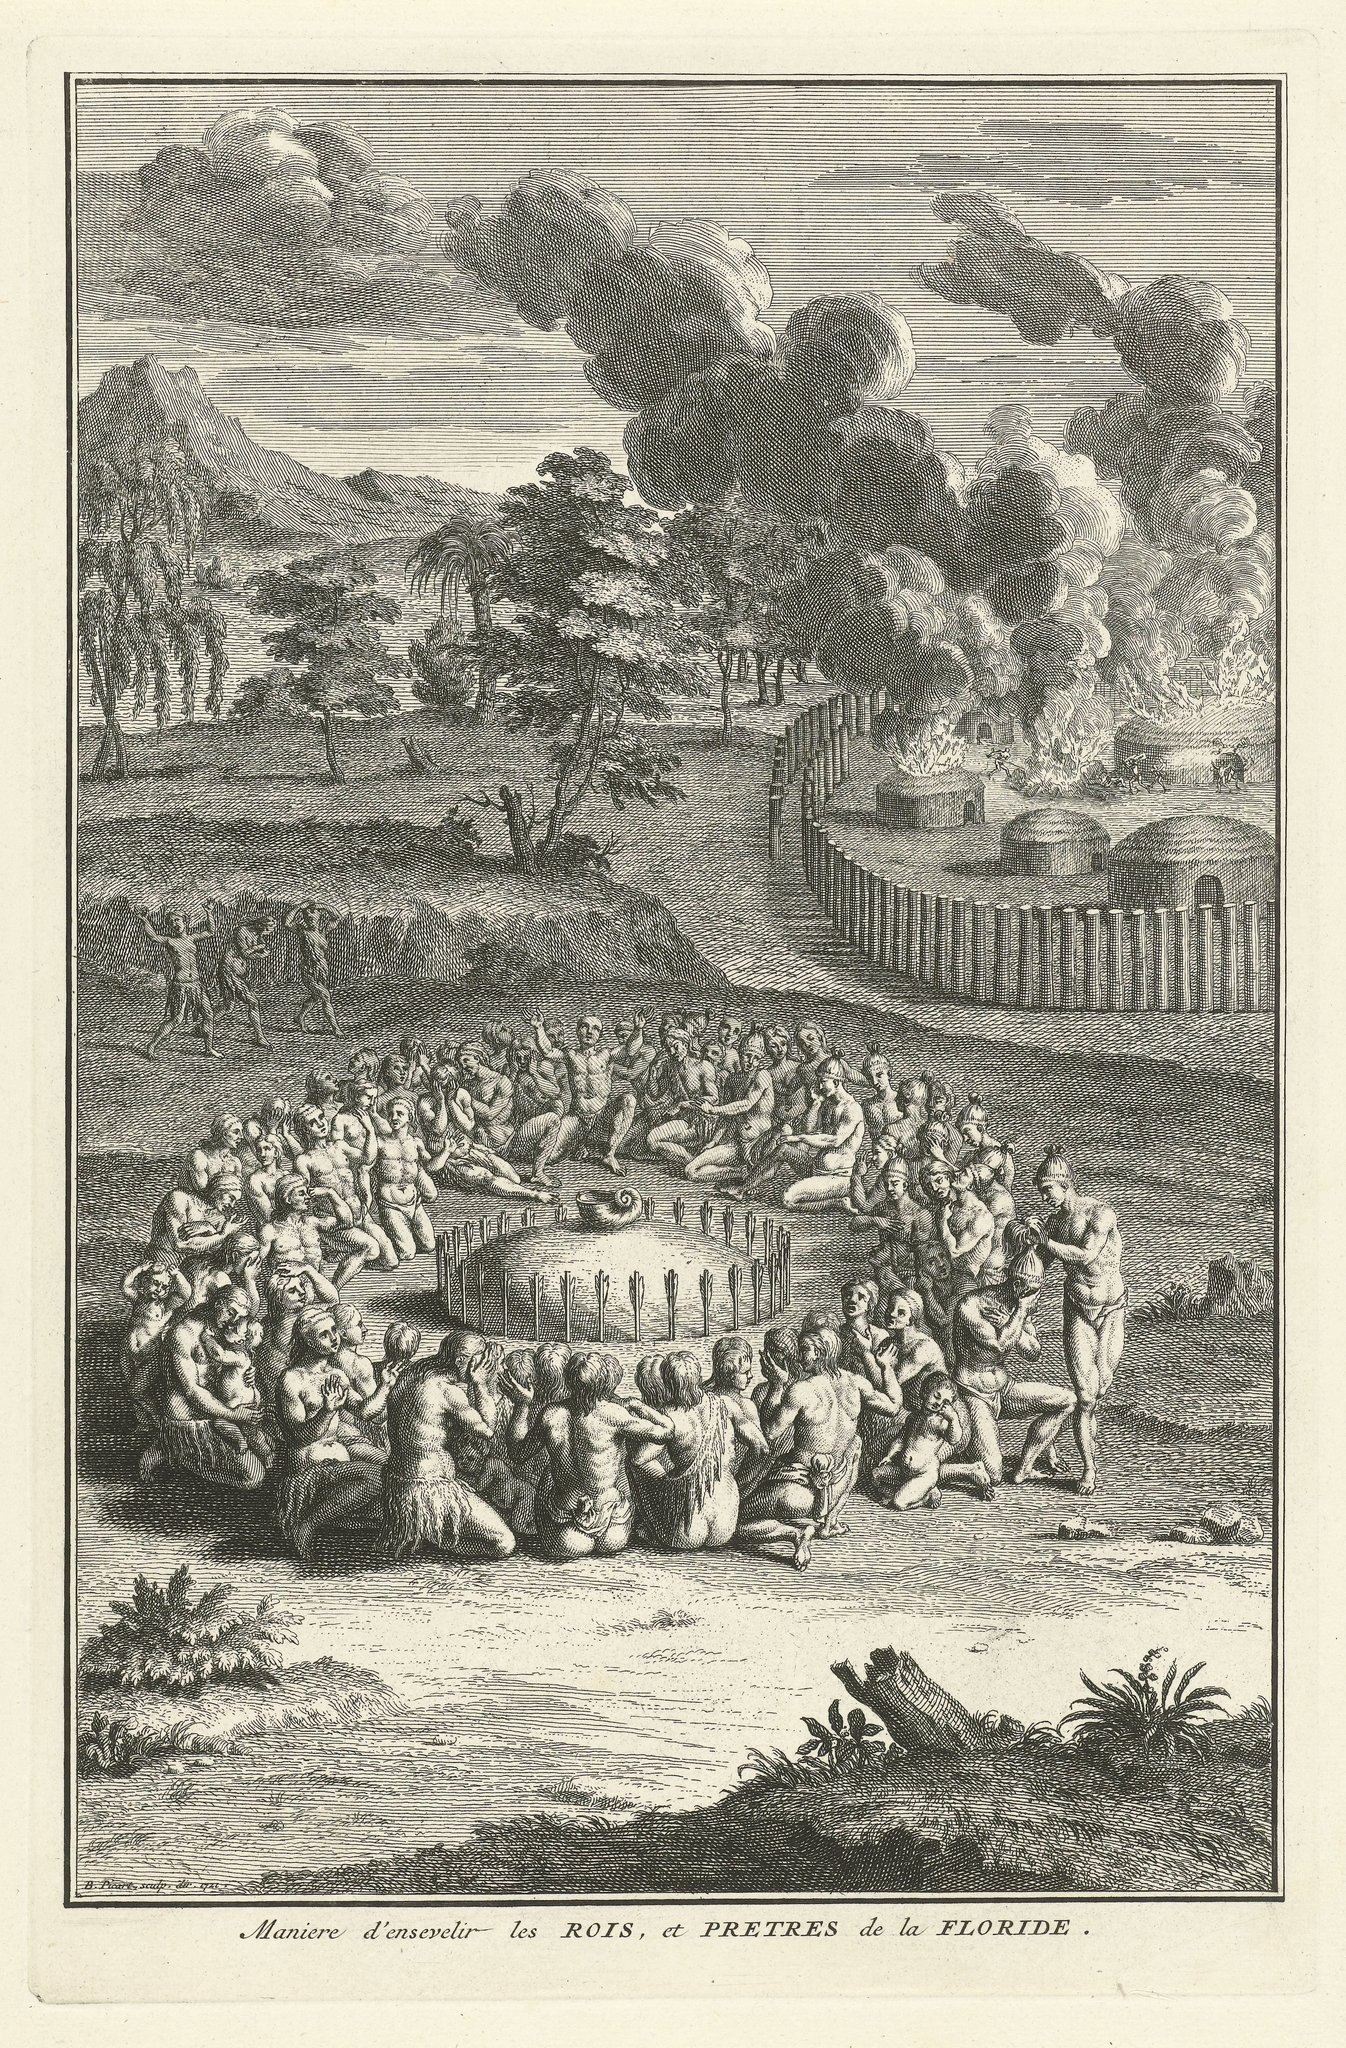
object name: print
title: Begrafenisplechtigheid van de oorspronkelijke bevolking van Florida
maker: bernard picart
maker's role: draughtsman, print maker, publisher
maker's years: 1673-1733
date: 1721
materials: paper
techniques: engraving, etching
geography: amsterdam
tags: ritual practices ~ death and burial (american indian religions), indigenous peoples of north america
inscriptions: collector's mark: Lugt 2228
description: Prent ook gebruikt in: Picart, Bernard. Naaukeurige beschryving der uitwendige godtsdienst-plichten, kerk-zeden en gewoontens van alle volkeren der waereldt. [Vertaald in het Nederlands door] Moubach, Abraham. Den Haag, Amsterdam, Rotterdam: Rutgert Alberts, Hermannus Uytwerf, Jan Daniel Beman, Isaac van der Kloot, 1727-1738.